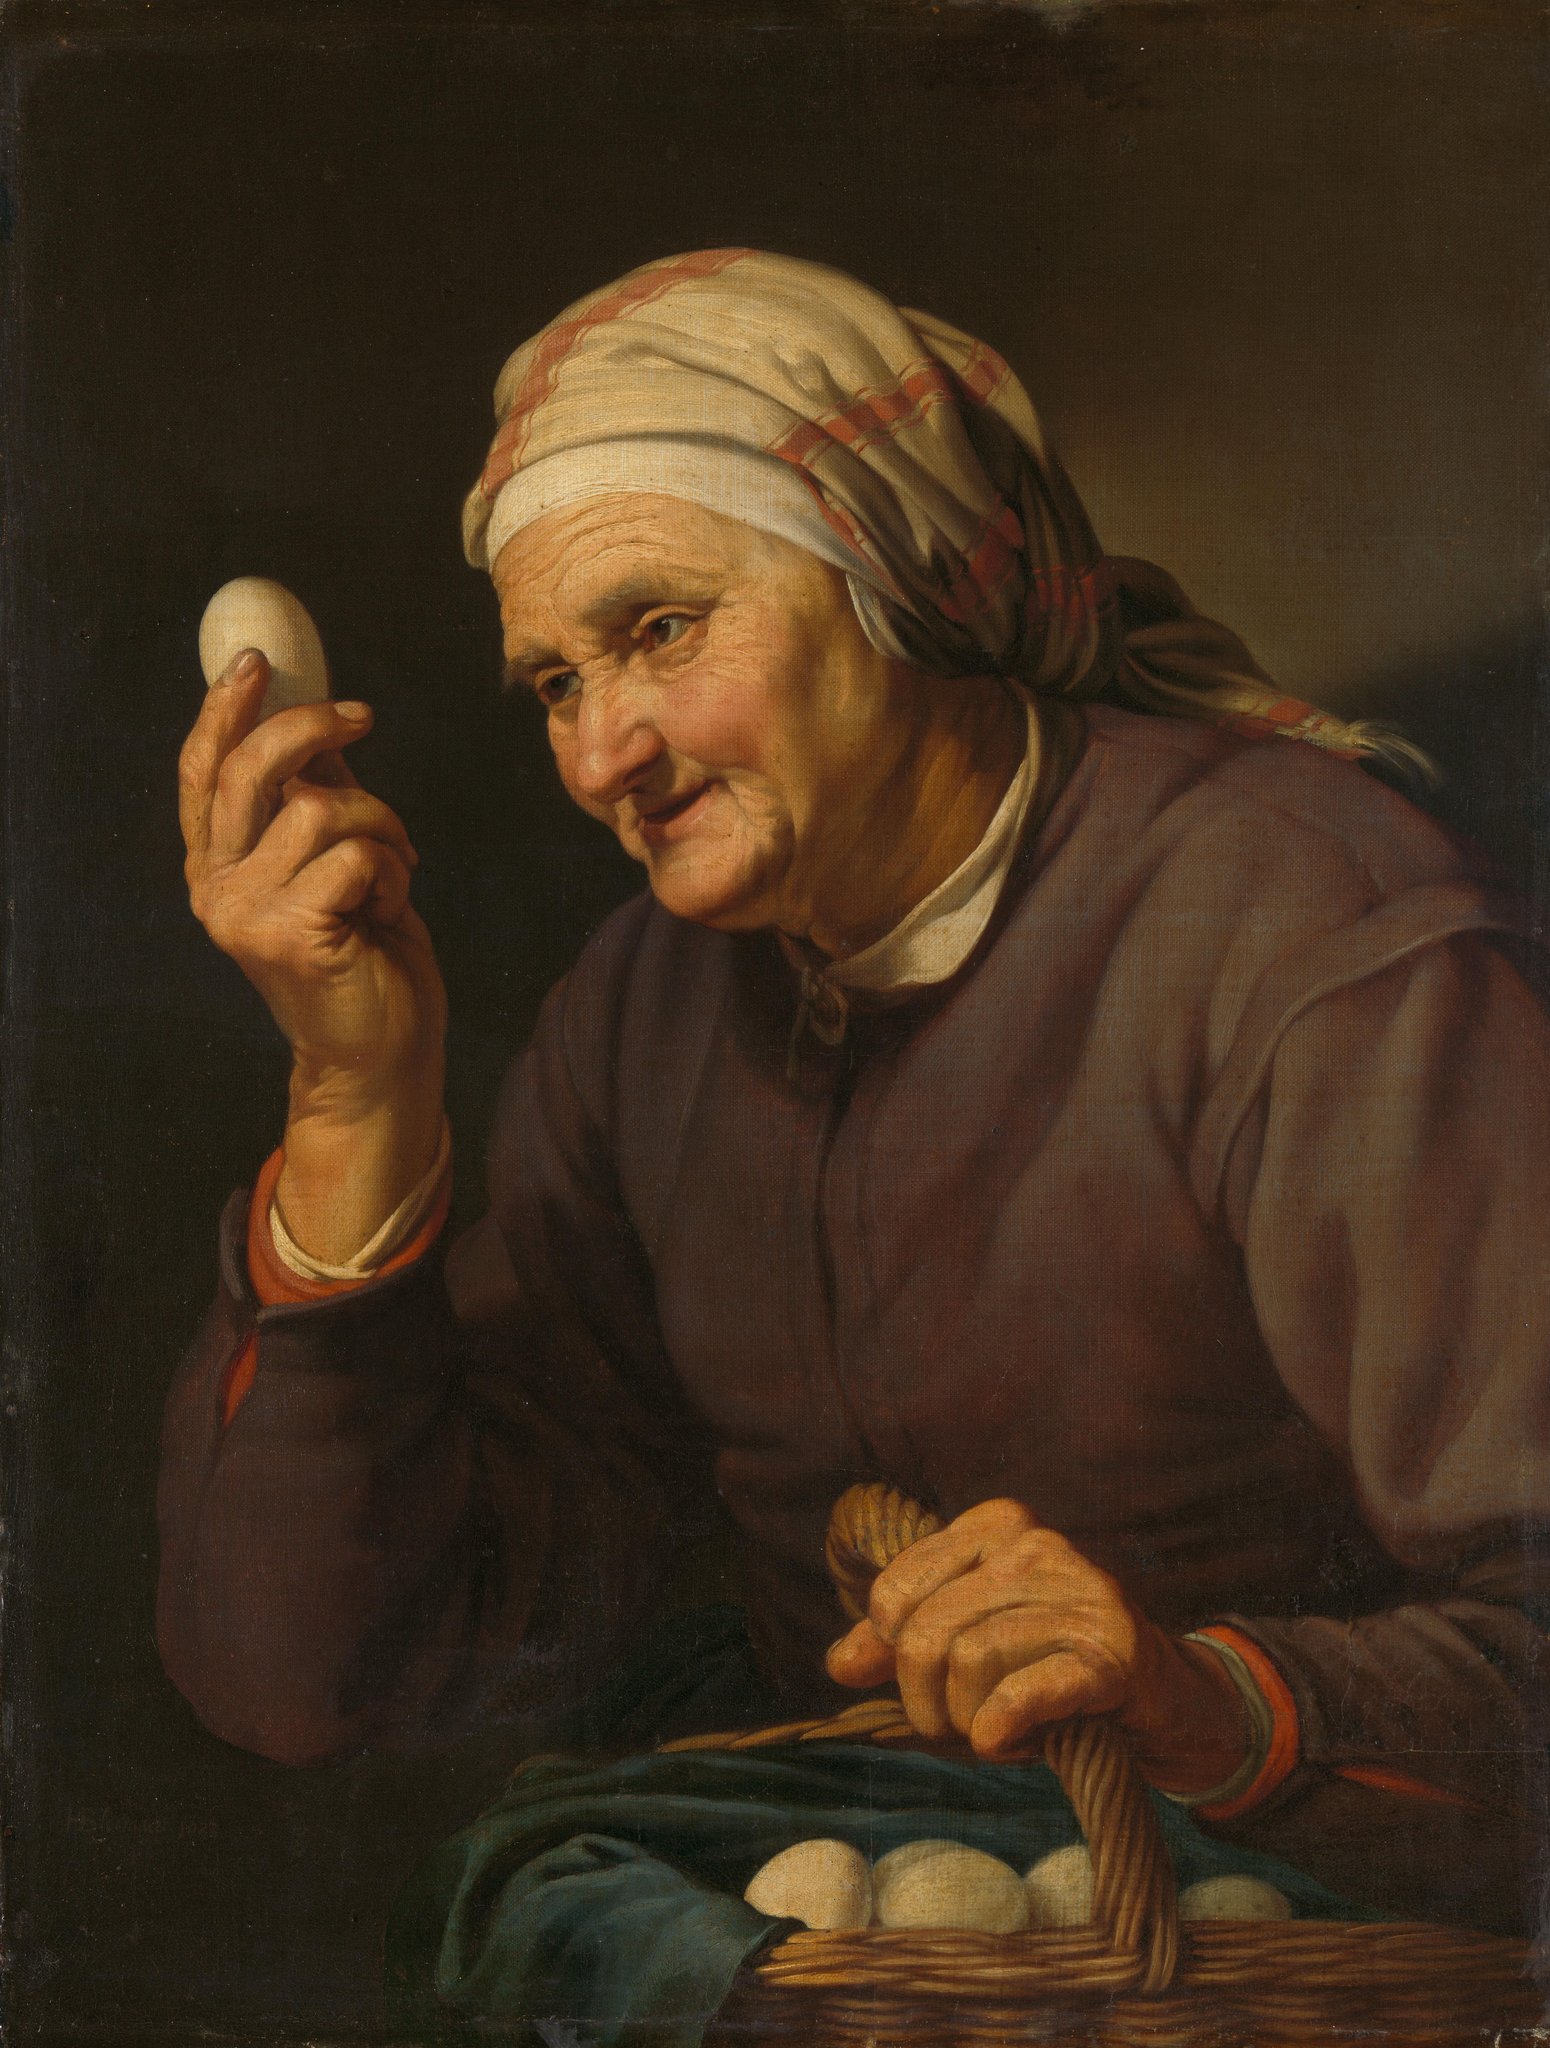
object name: painting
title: Old Woman Selling Eggs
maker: hendrick bloemaert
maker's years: 1601-1672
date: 1632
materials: canvas, oil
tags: persons engaged in trade and commerce - bb - women engaged in trade and commerce, old woman, eggs, egg-dishes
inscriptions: signature and date, lower left (H and B ligated): ‘HBloemaert.1632.’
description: De eierenkoopvrouw. Oude vrouw met een mand met eieren.